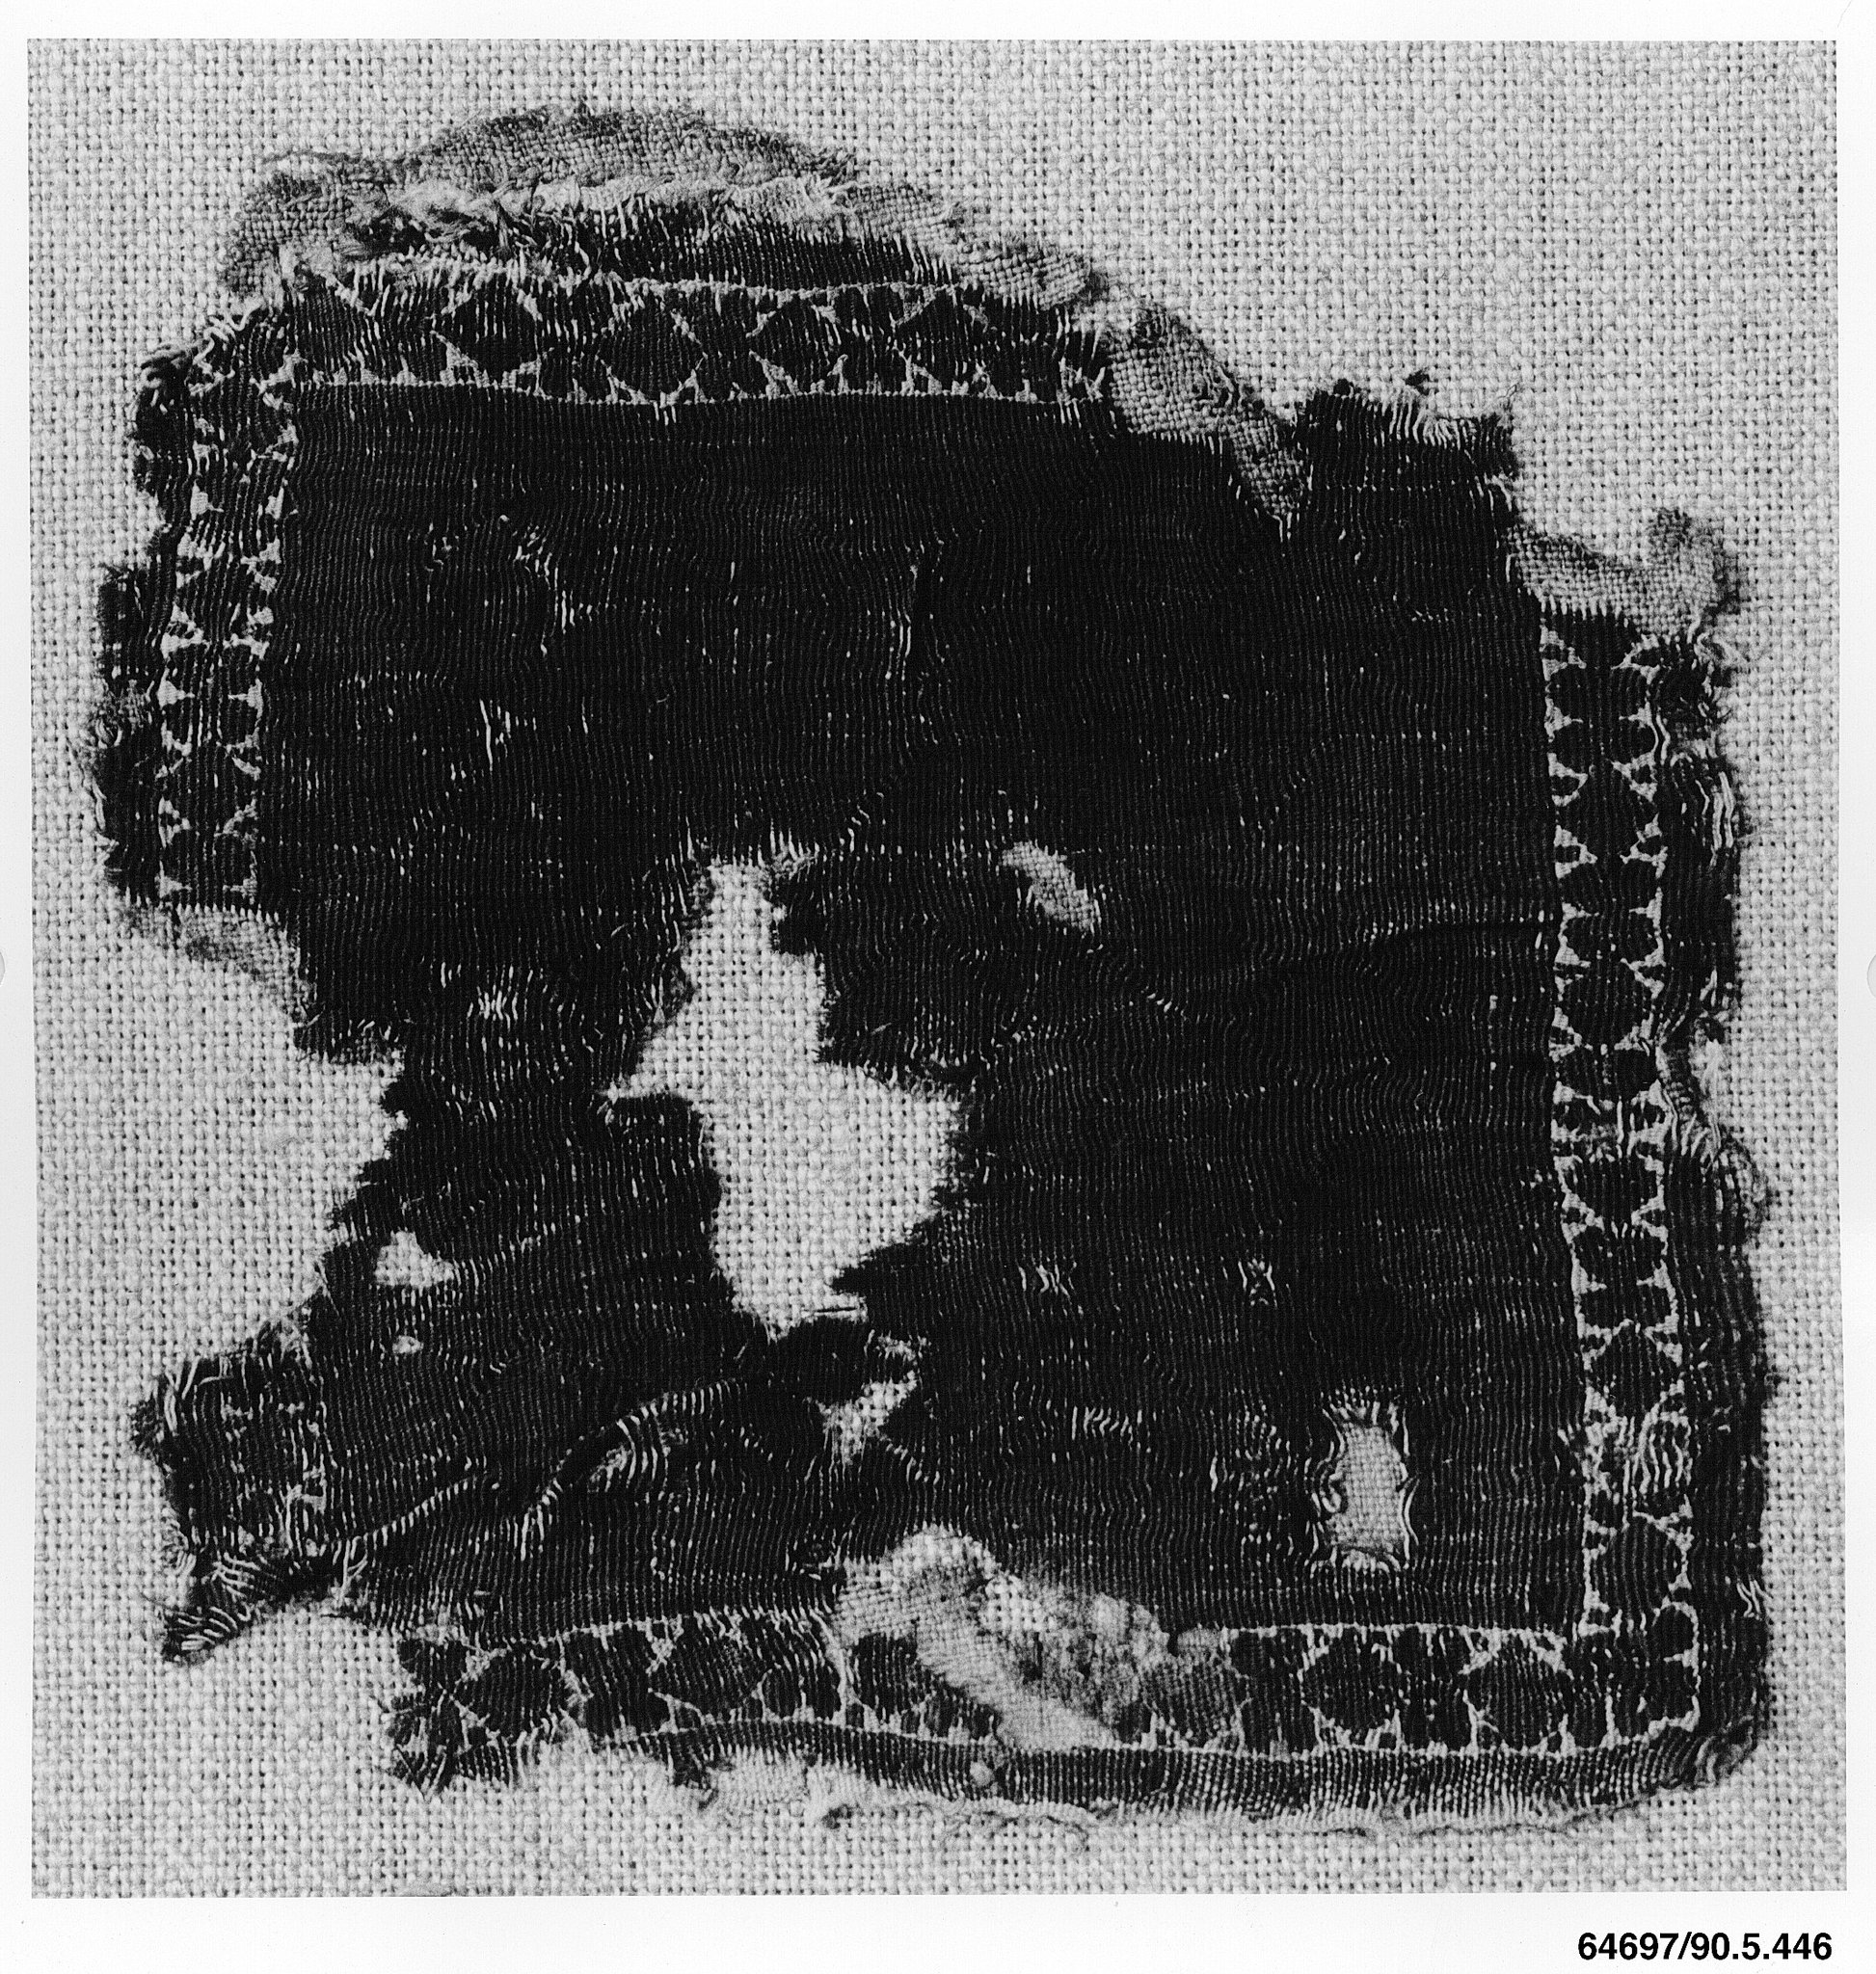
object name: textile fragment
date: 201-400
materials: linen, wool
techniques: weave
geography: egypt